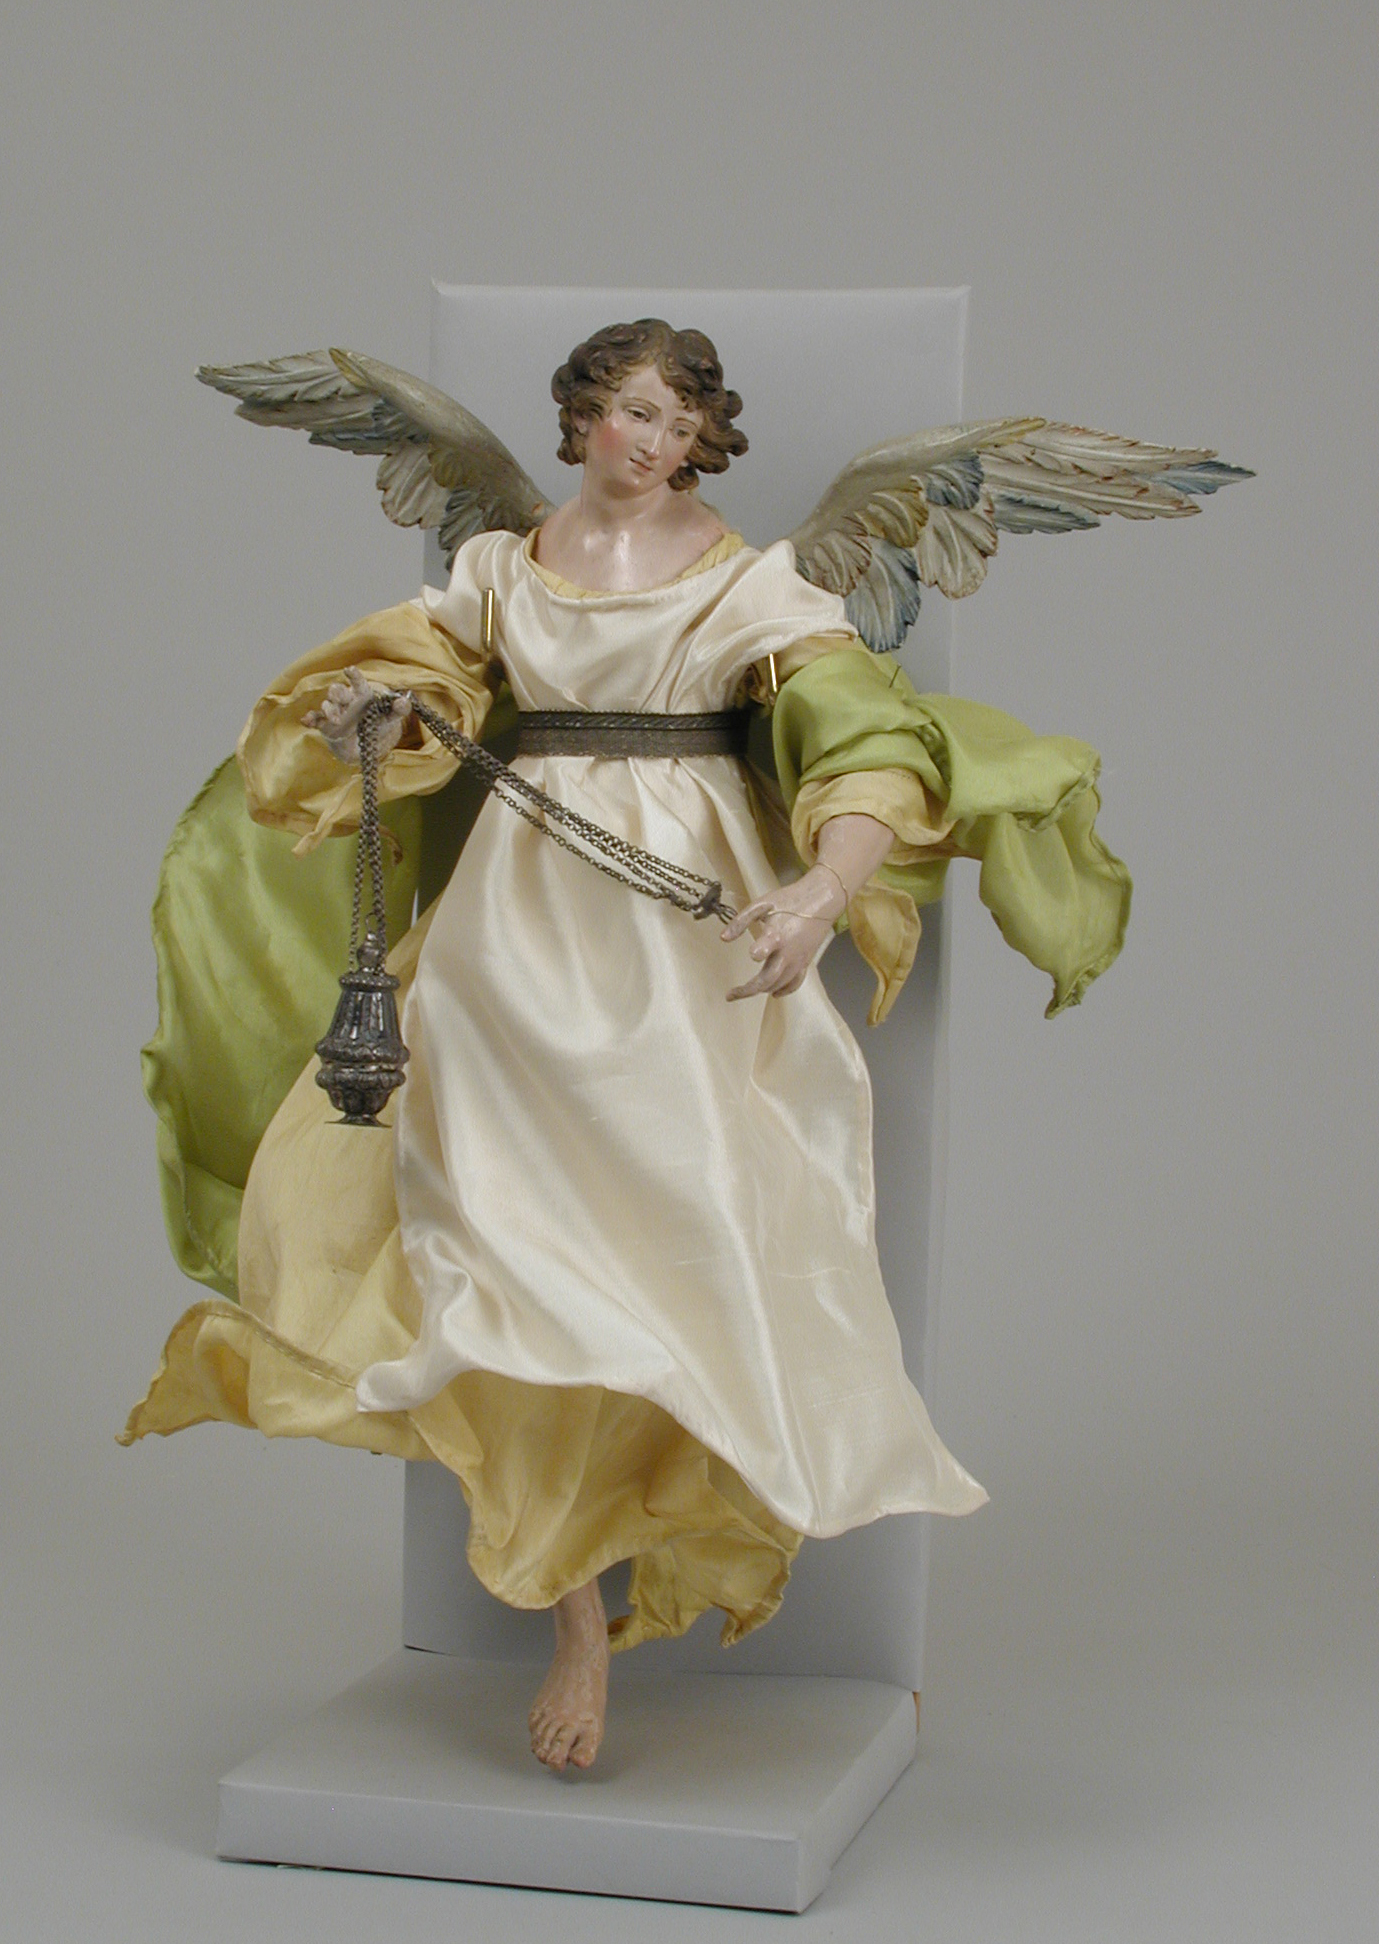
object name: crèche figure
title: Angel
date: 1751-1800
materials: terracotta, fiber, metal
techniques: polychrome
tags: angels,censers